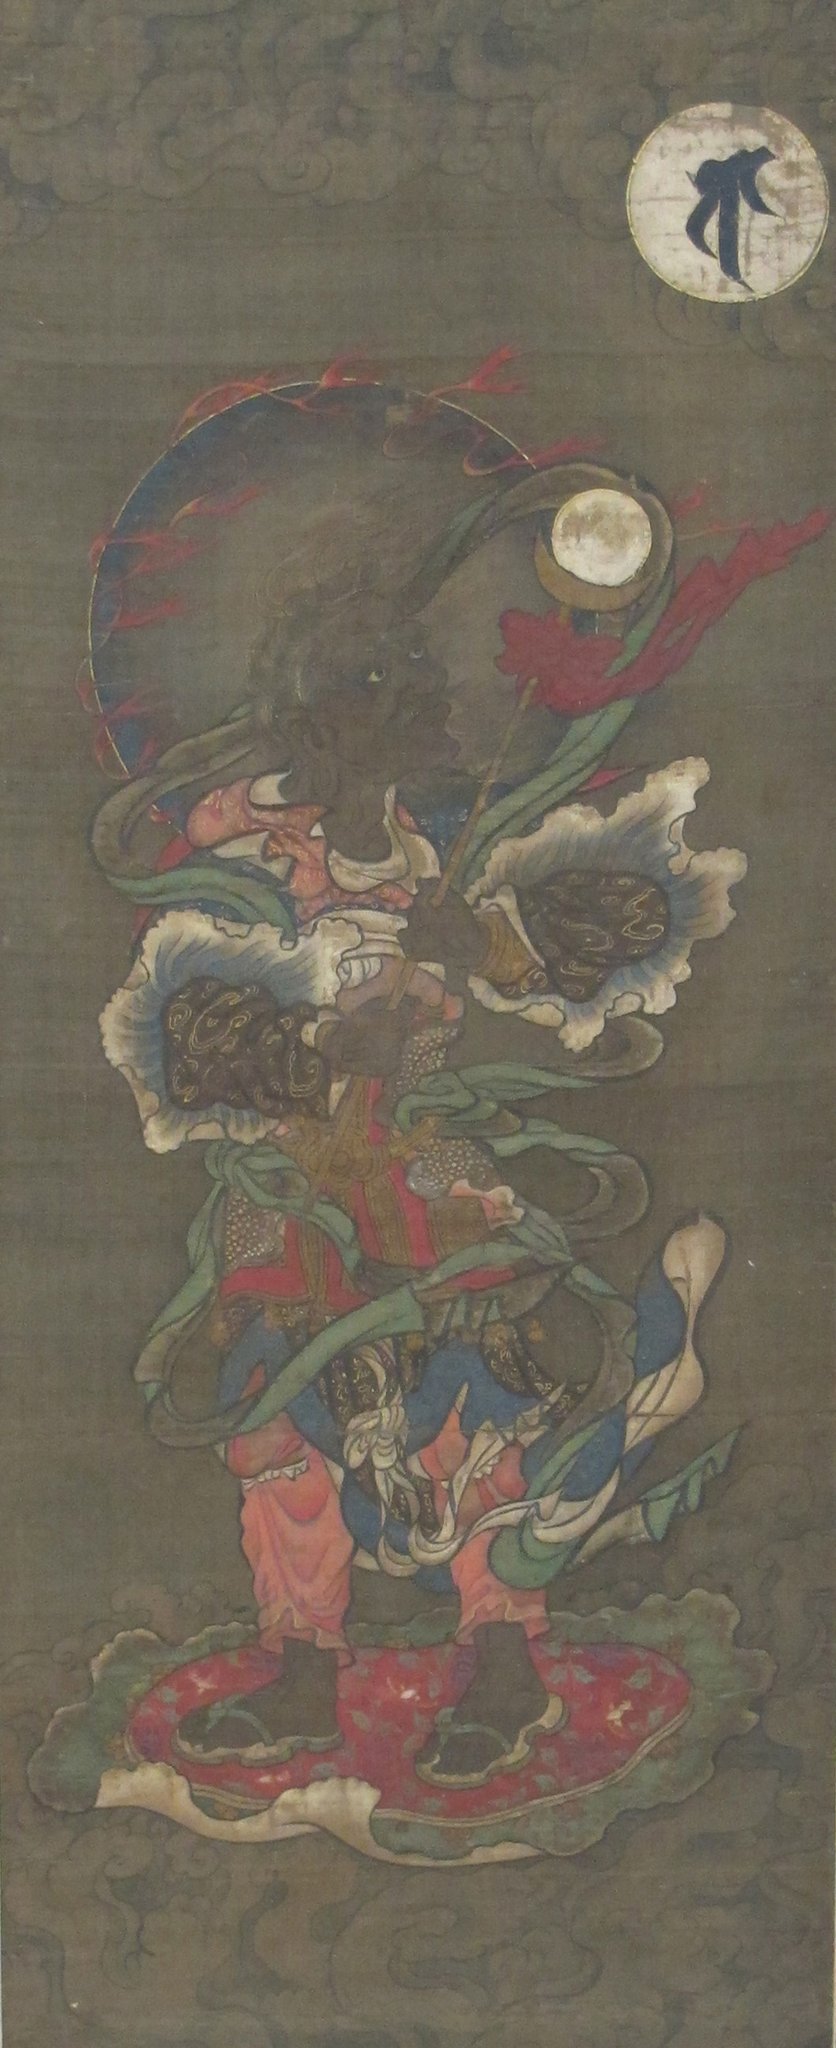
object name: painting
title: One of the Twelve Celestial Guardians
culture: japanese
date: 1351-1400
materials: gold, ink, panel, silk